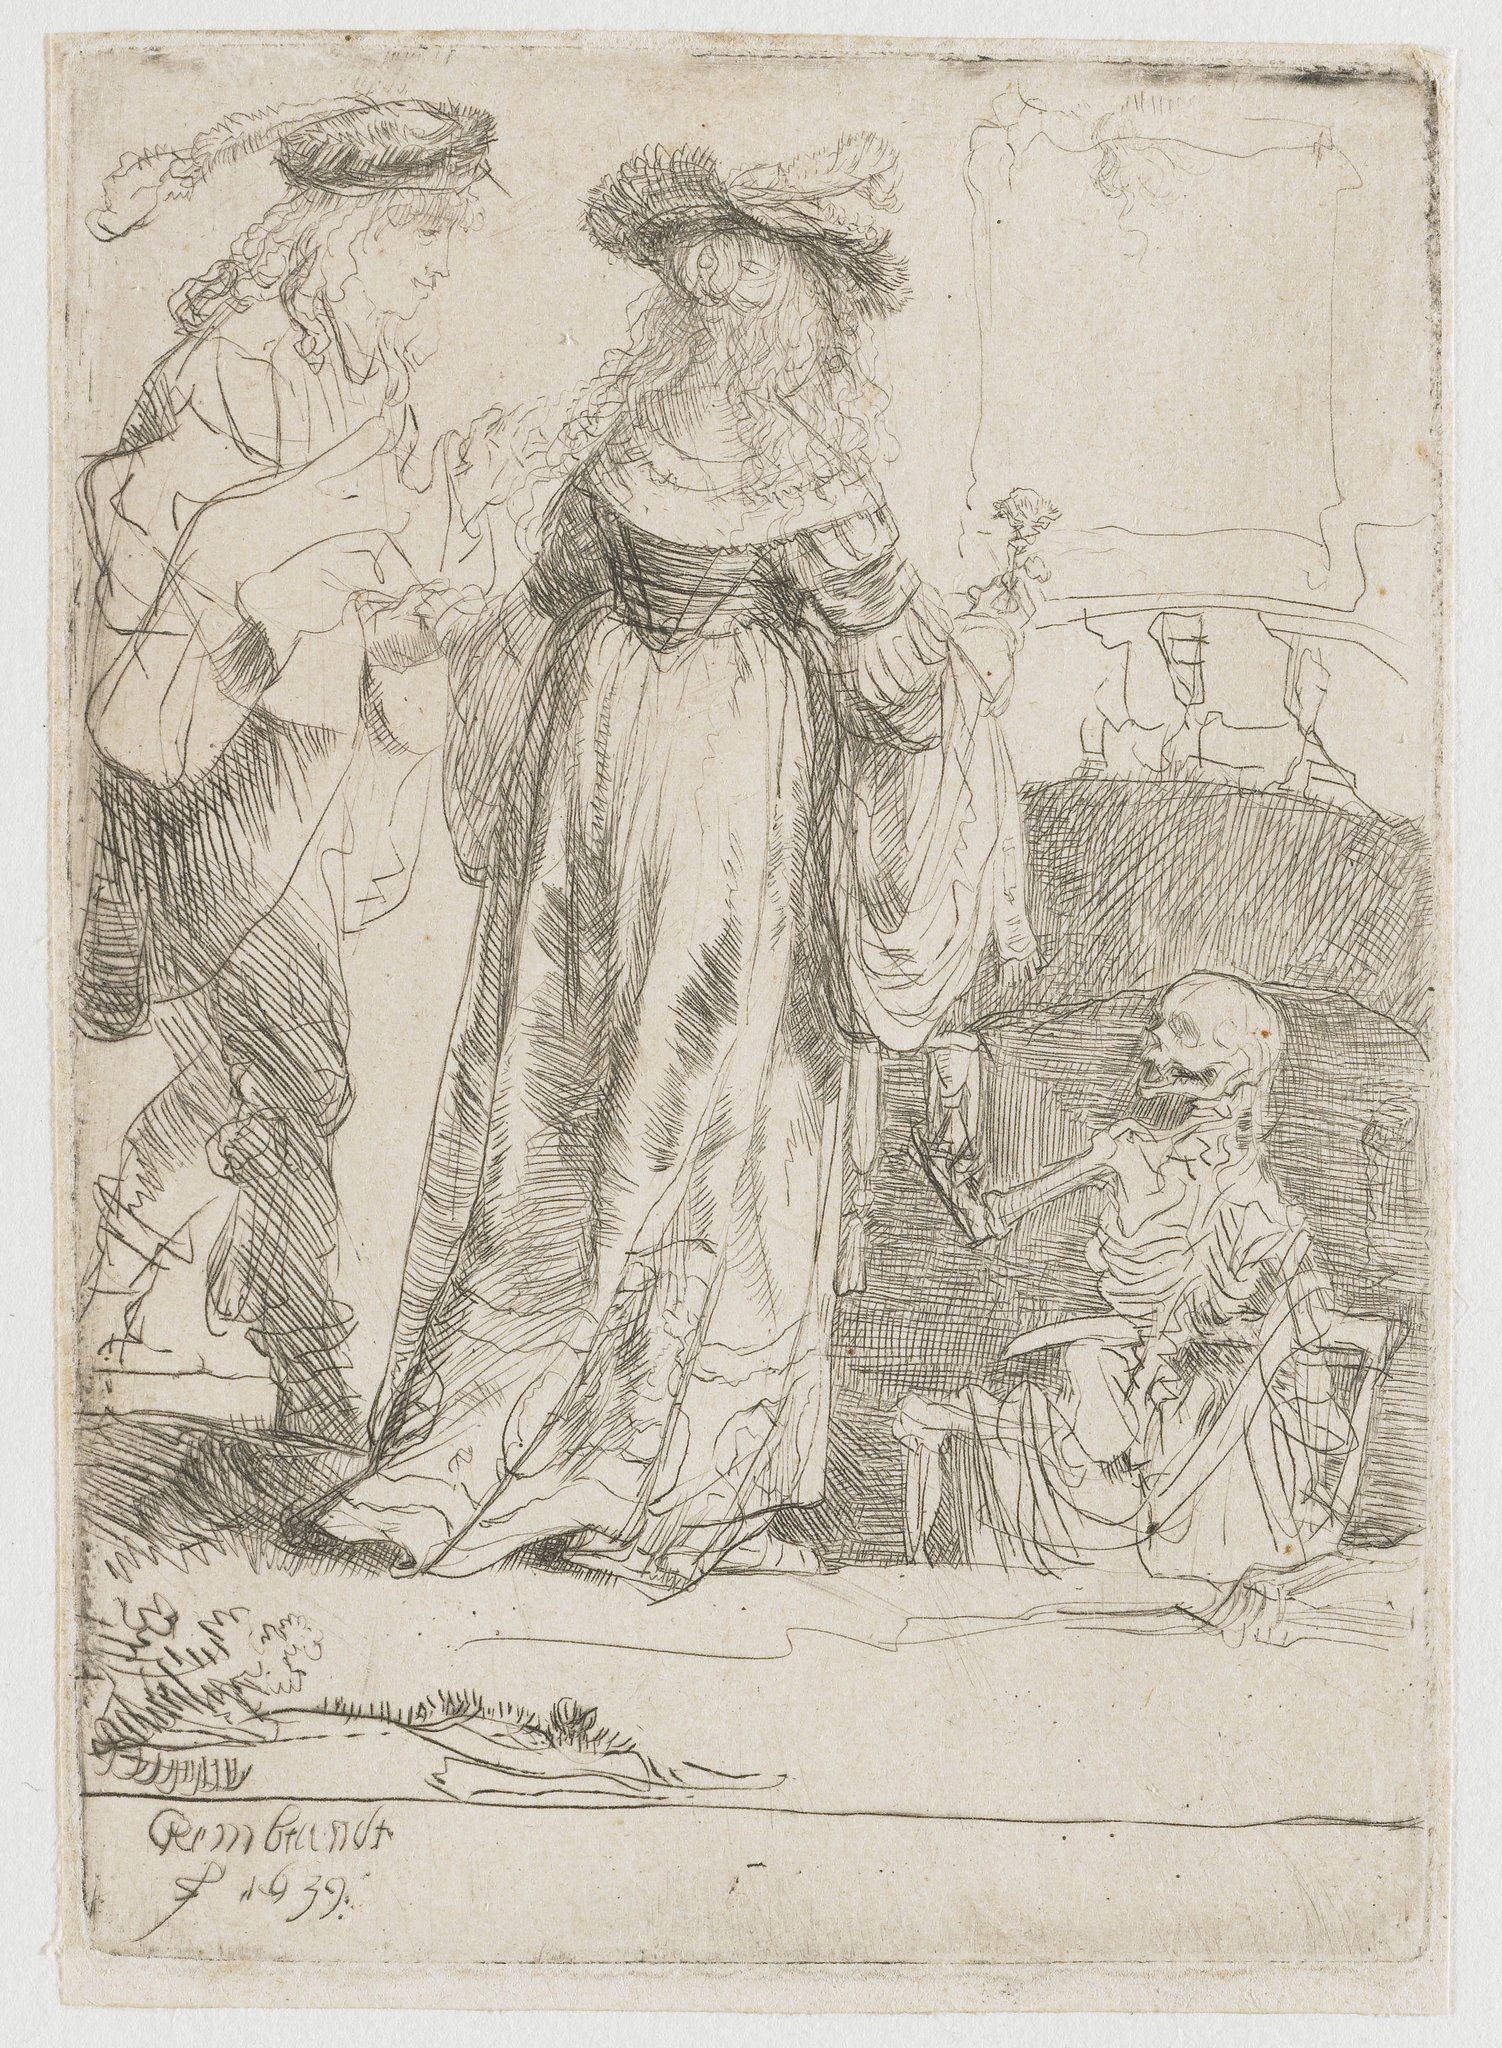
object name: print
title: Death Appearing to a Wedded Couple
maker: rembrandt van rijn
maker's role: draughtsman, painter, print maker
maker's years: 1606-1669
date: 1639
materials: paper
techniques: etching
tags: dance of death; death together with one or more human beings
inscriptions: signature and date: ‘Rembrandt f. 1639’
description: A young couple stands hand in hand before an open tomb, from which Death rises up in the guise of a skeleton draped in his tattered shroud and holding an hourglass and a scythe. Rembrandt depicts the elegantly clad couple looking straight into the eyes of the Grim Reaper. They are thus directly confronted by the transience of life.